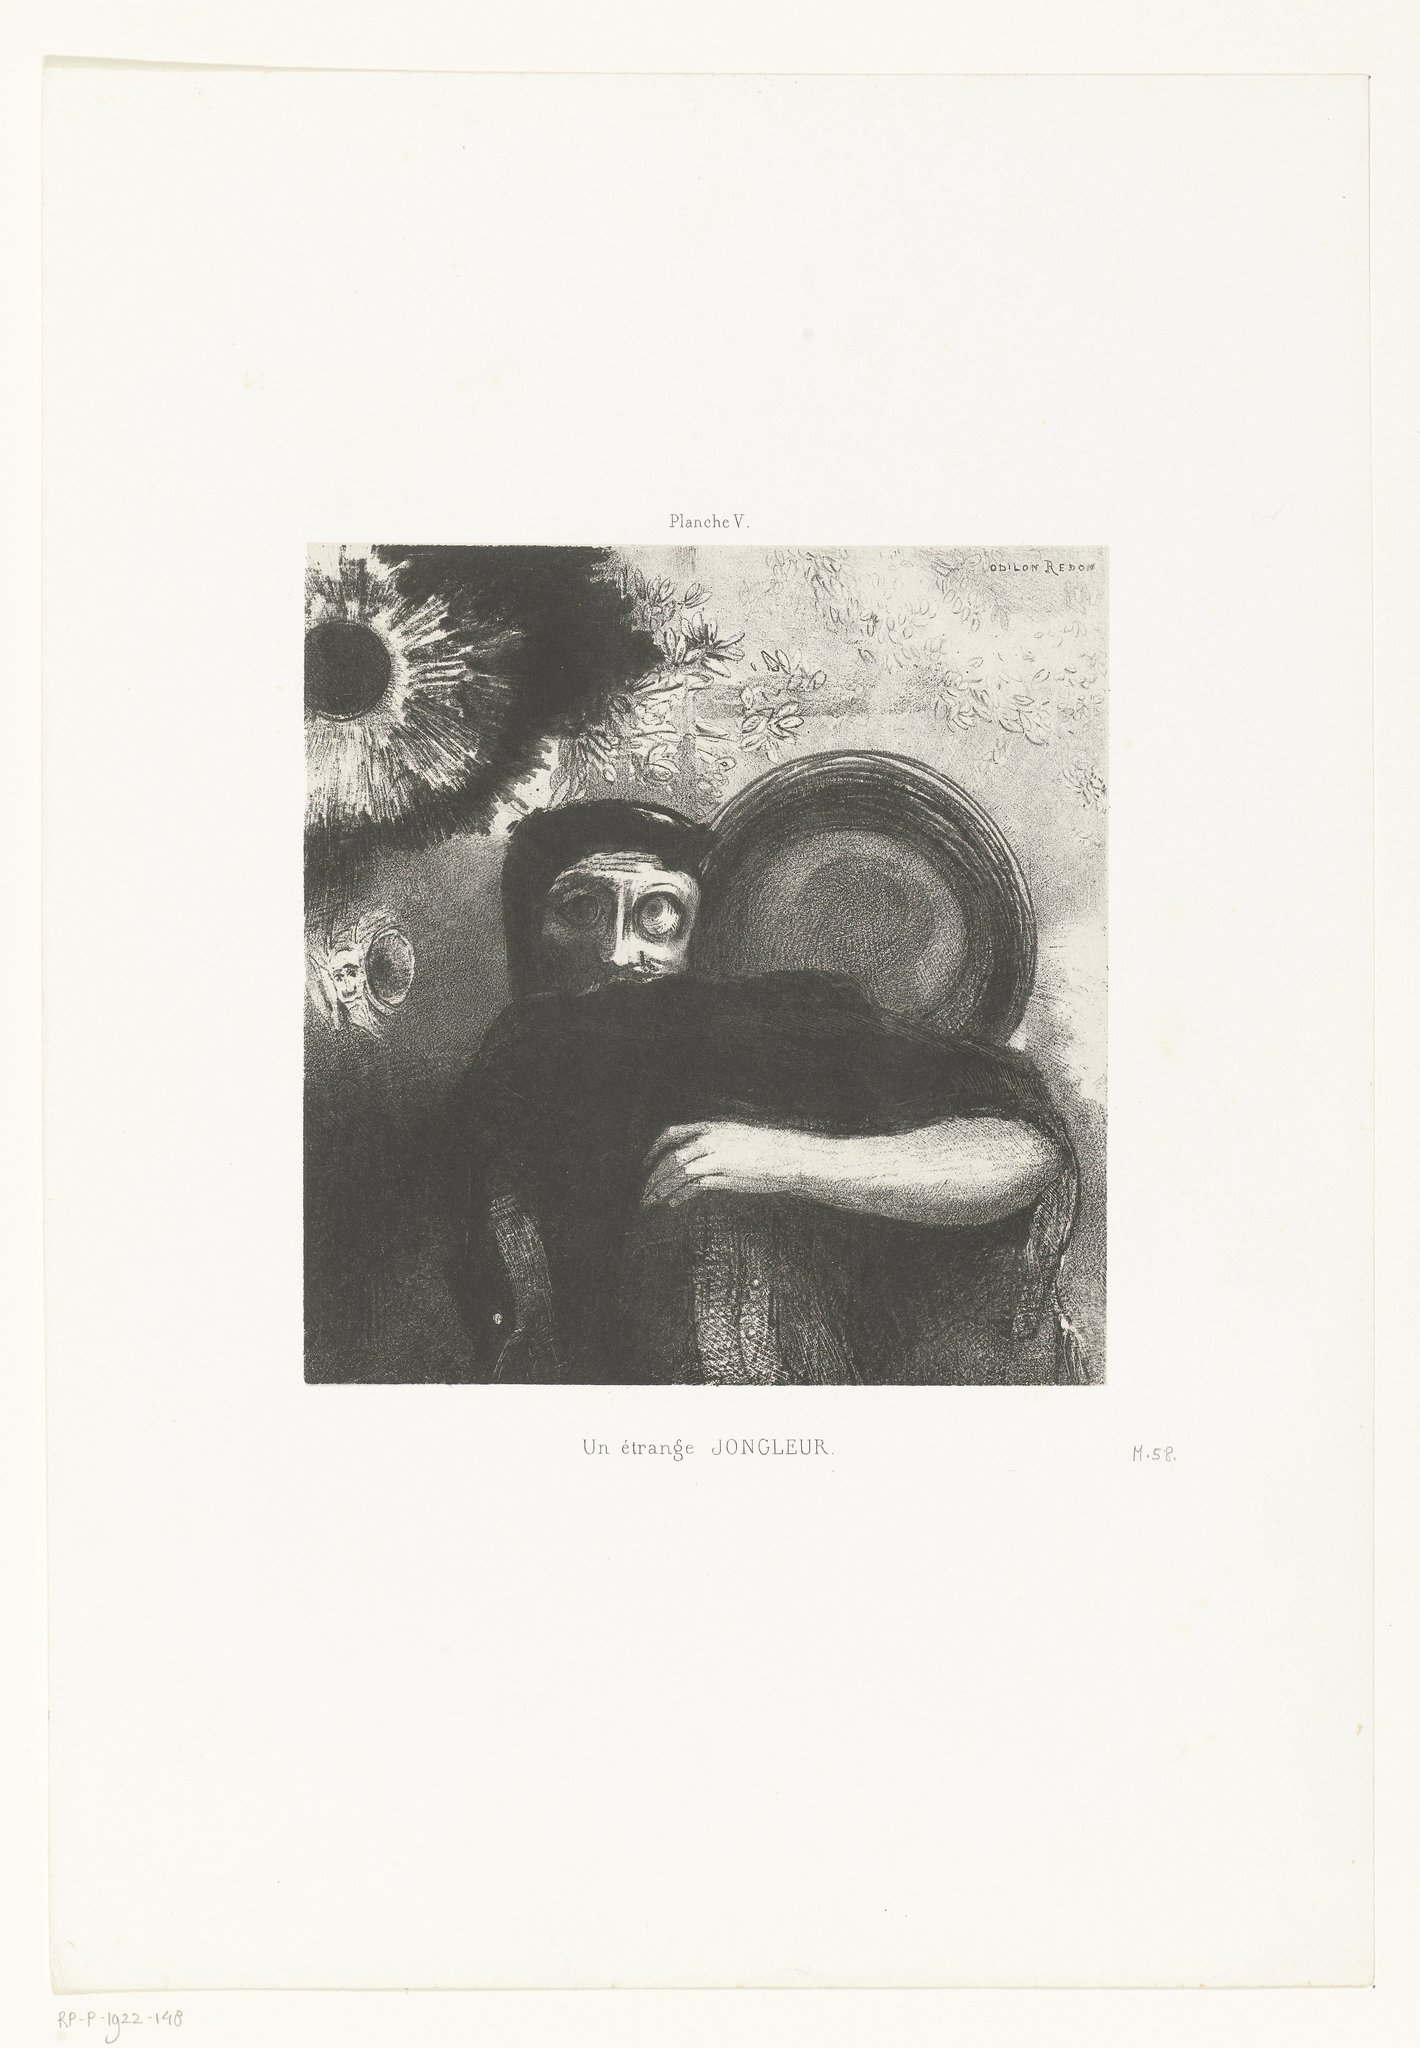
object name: print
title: Un étrange JONGLEUR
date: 1885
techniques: printmaking, lithograph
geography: paris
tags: illusionist, conjurer, juggler, 'legerdemain'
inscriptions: collector's mark: Lugt 2228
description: Een man, van voren gezien, met grote ogen, houdt zijn arm voor zich omhoog. Rechts van hem een grote cirkel, links een vliegend wezen met grote oren.